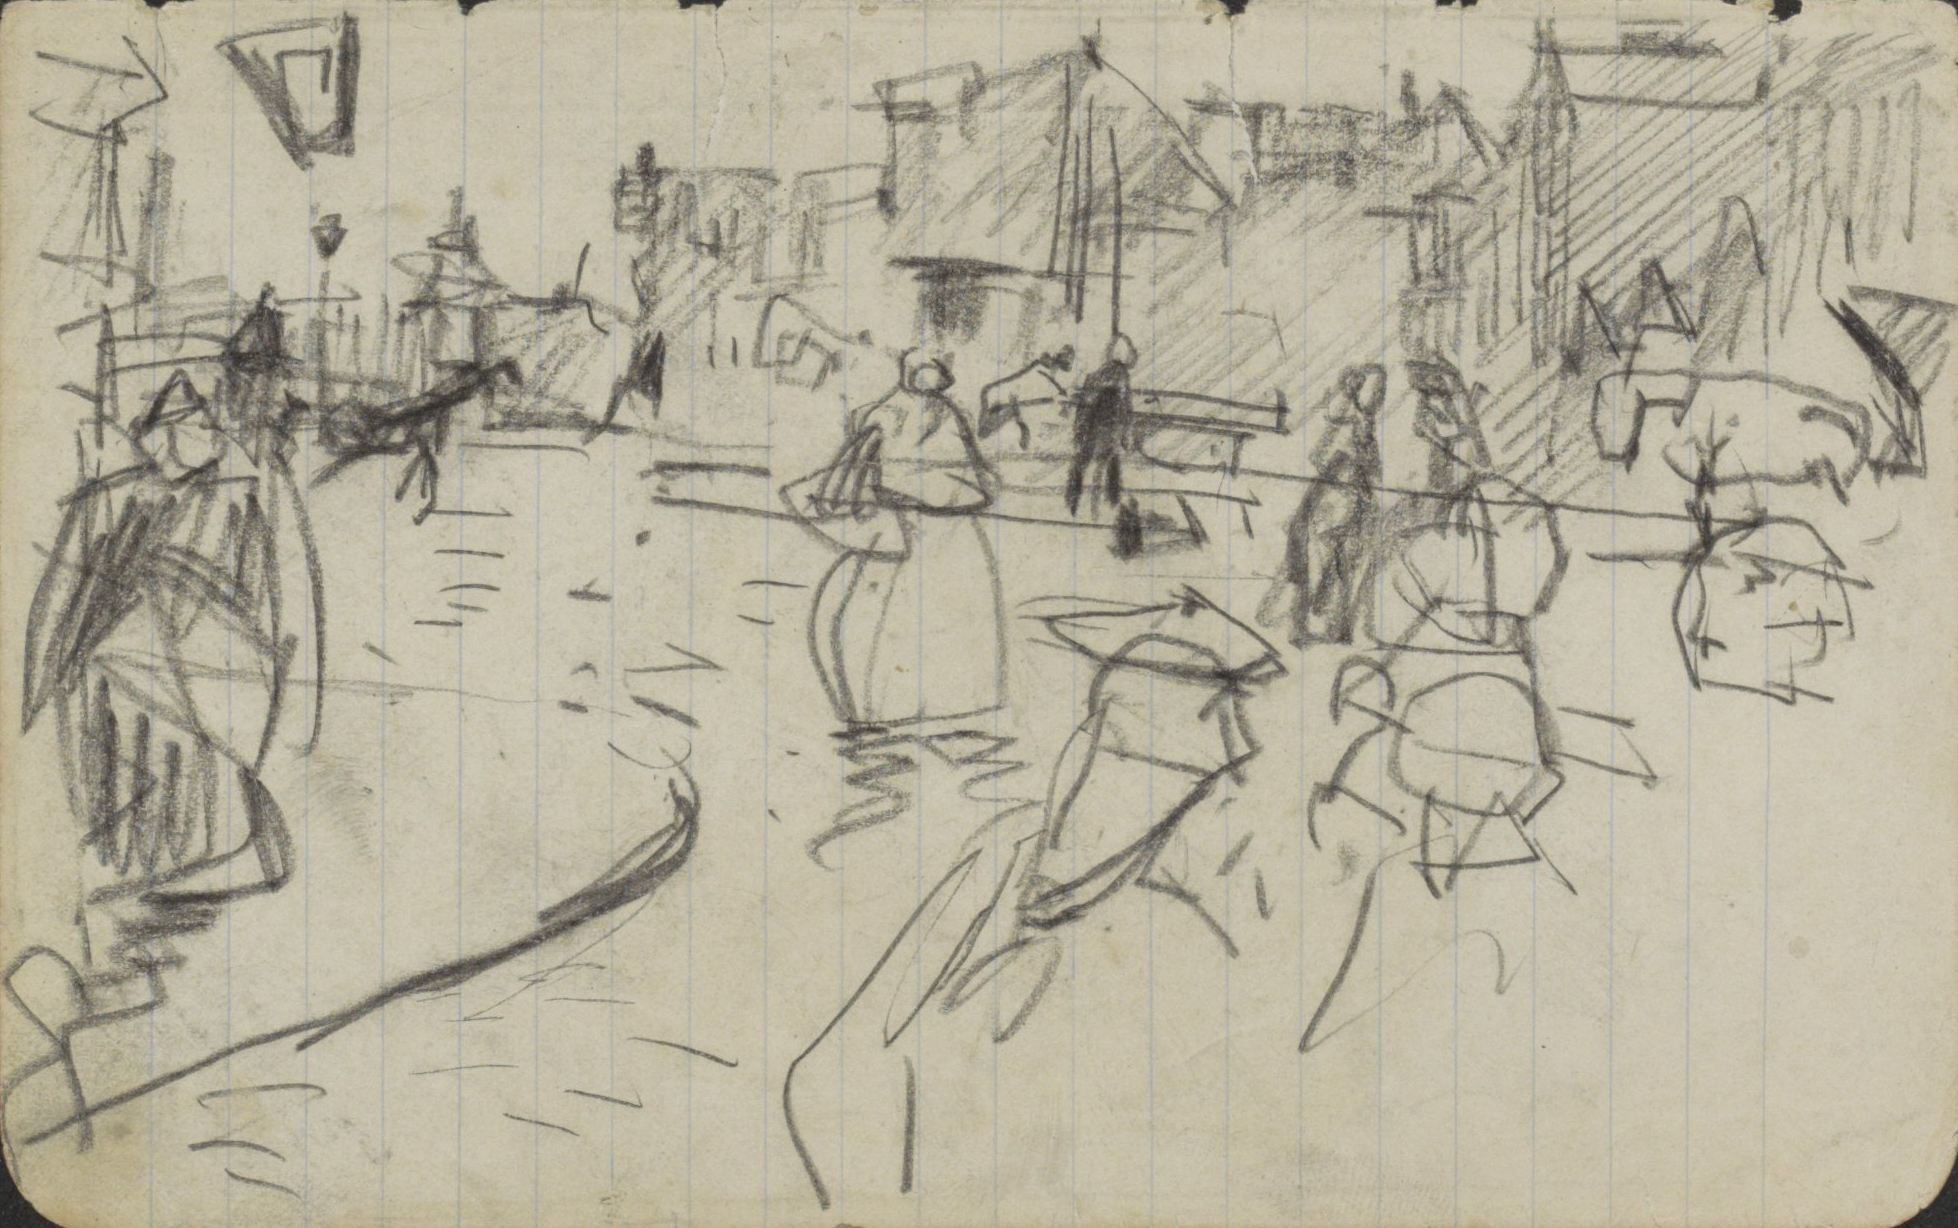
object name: drawing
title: Gezicht in Amsterdam, mogelijk het Rokin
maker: george hendrik breitner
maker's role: draughtsman, painter, print maker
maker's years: 1857-1923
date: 1886-1923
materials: chalk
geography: amsterdam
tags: street (+ city(-scape) with figures, staffage)